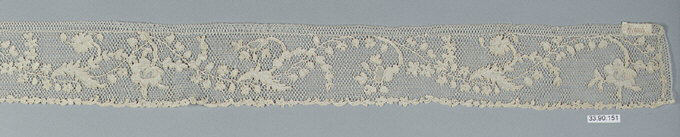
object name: edging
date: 1734-1766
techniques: lace